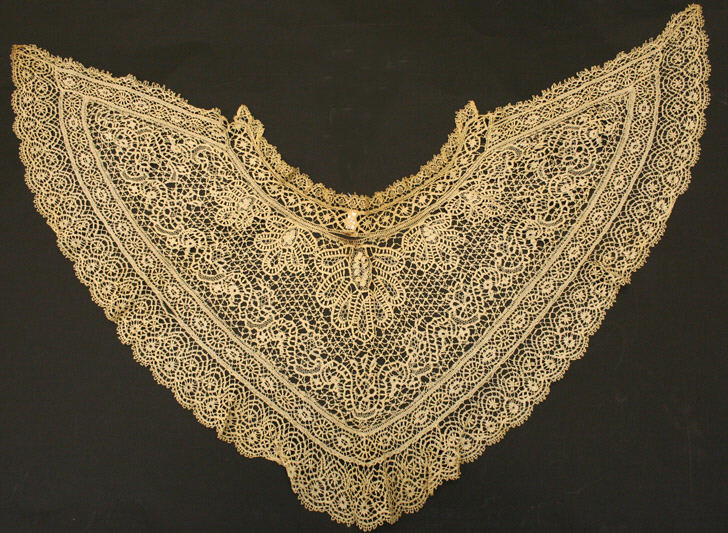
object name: collar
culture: american or european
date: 1867-1900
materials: linen